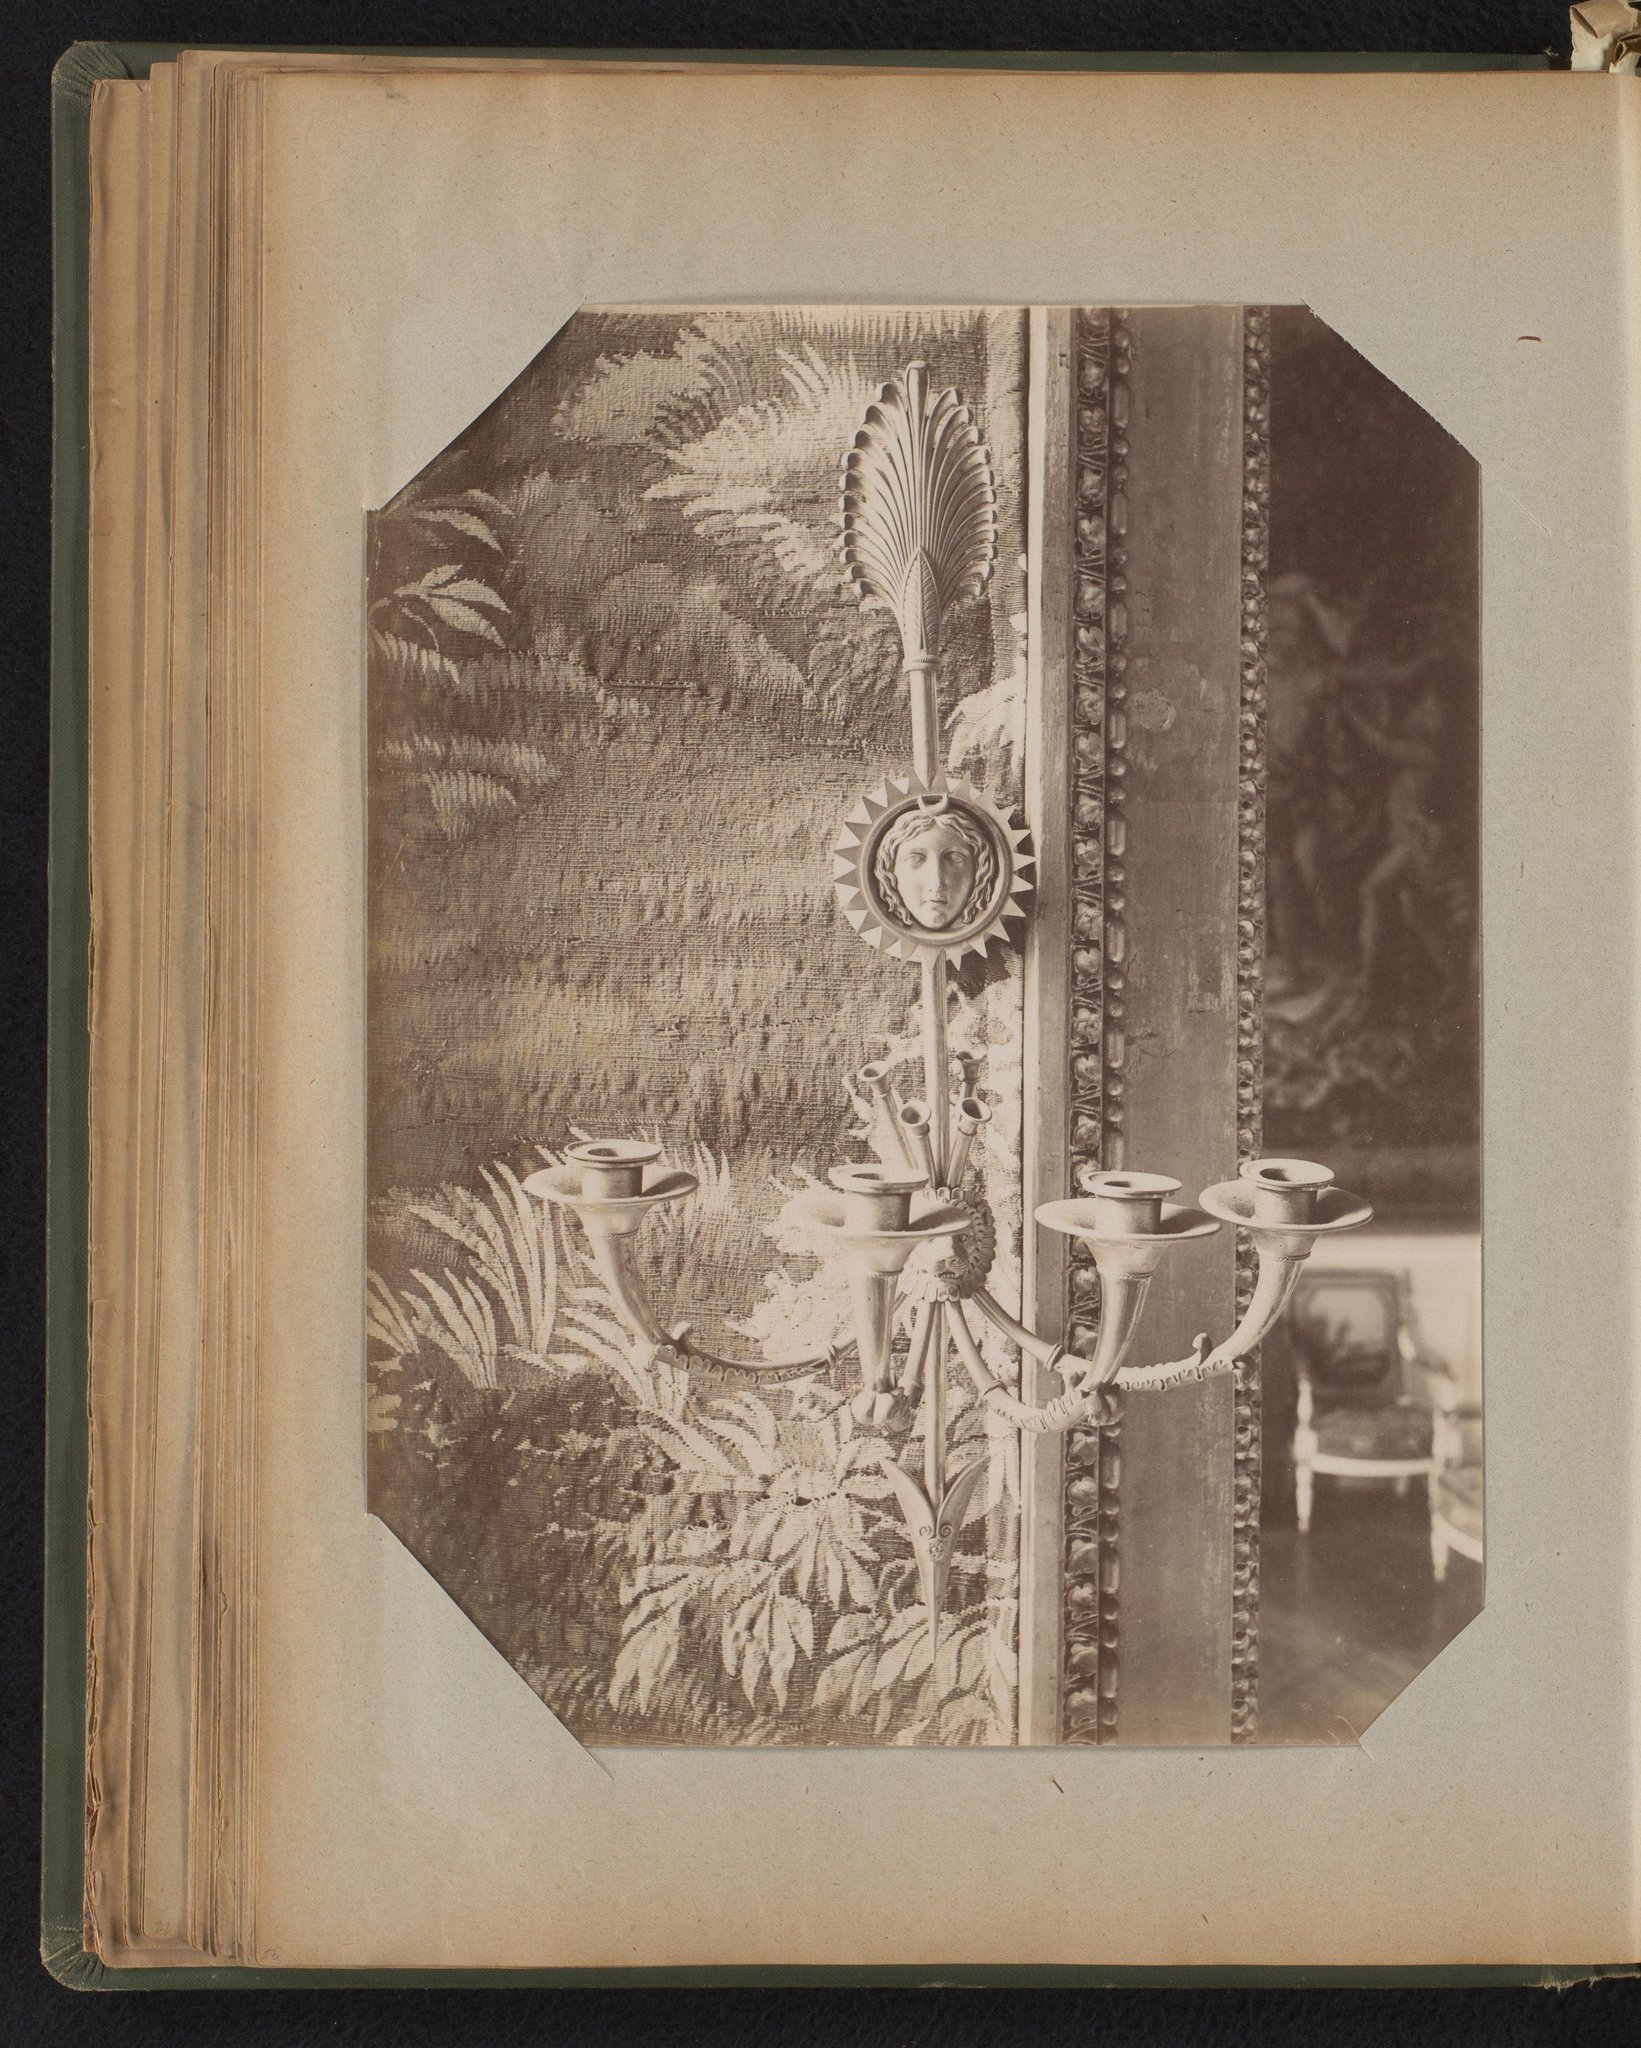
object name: photograph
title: Bronzen vierarmige muurkandelaar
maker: Anonymous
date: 1860-1900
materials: paper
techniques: albumen print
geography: france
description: Ter decoratie een gezicht in een zon en een leeuwenkop in een zon, beide in brons op de kandelaar. Onderdeel van een serie met betrekking tot het interieur van het paleis van Versailles met kroonluchters, deuren, portalen en meubelstukken.